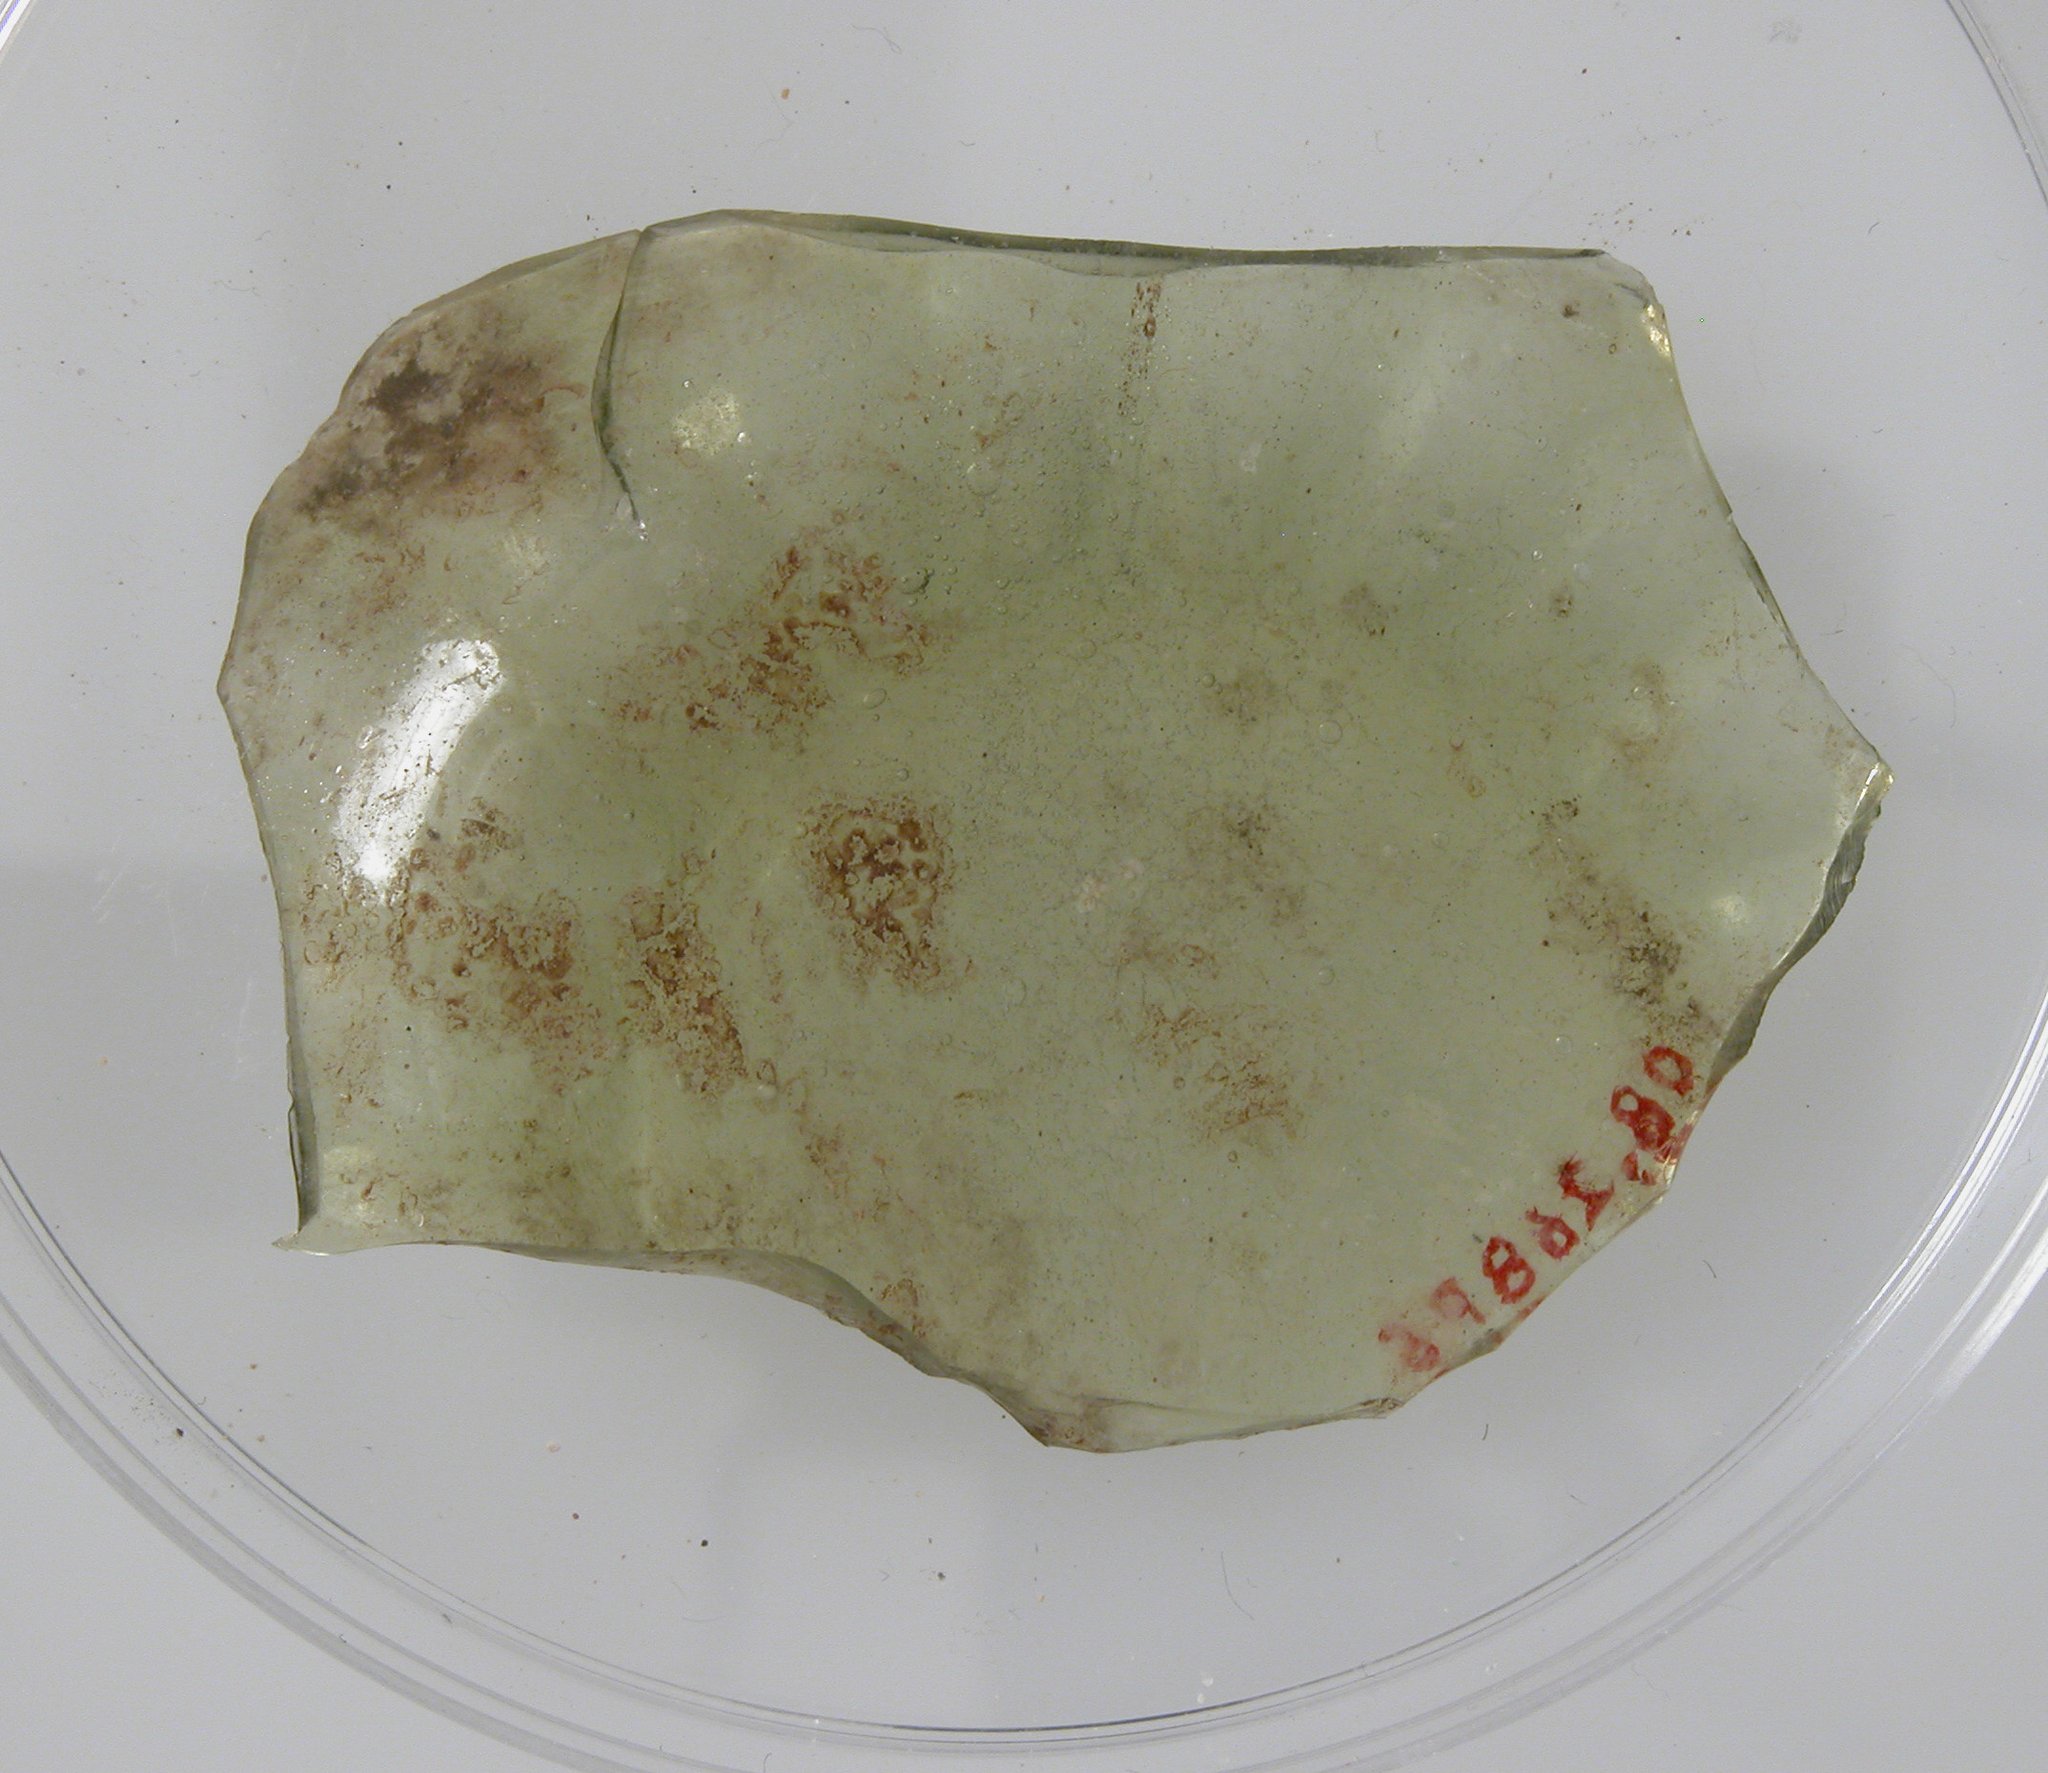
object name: fragment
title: Bottom of a Vessel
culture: coptic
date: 301-433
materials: glass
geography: egypt